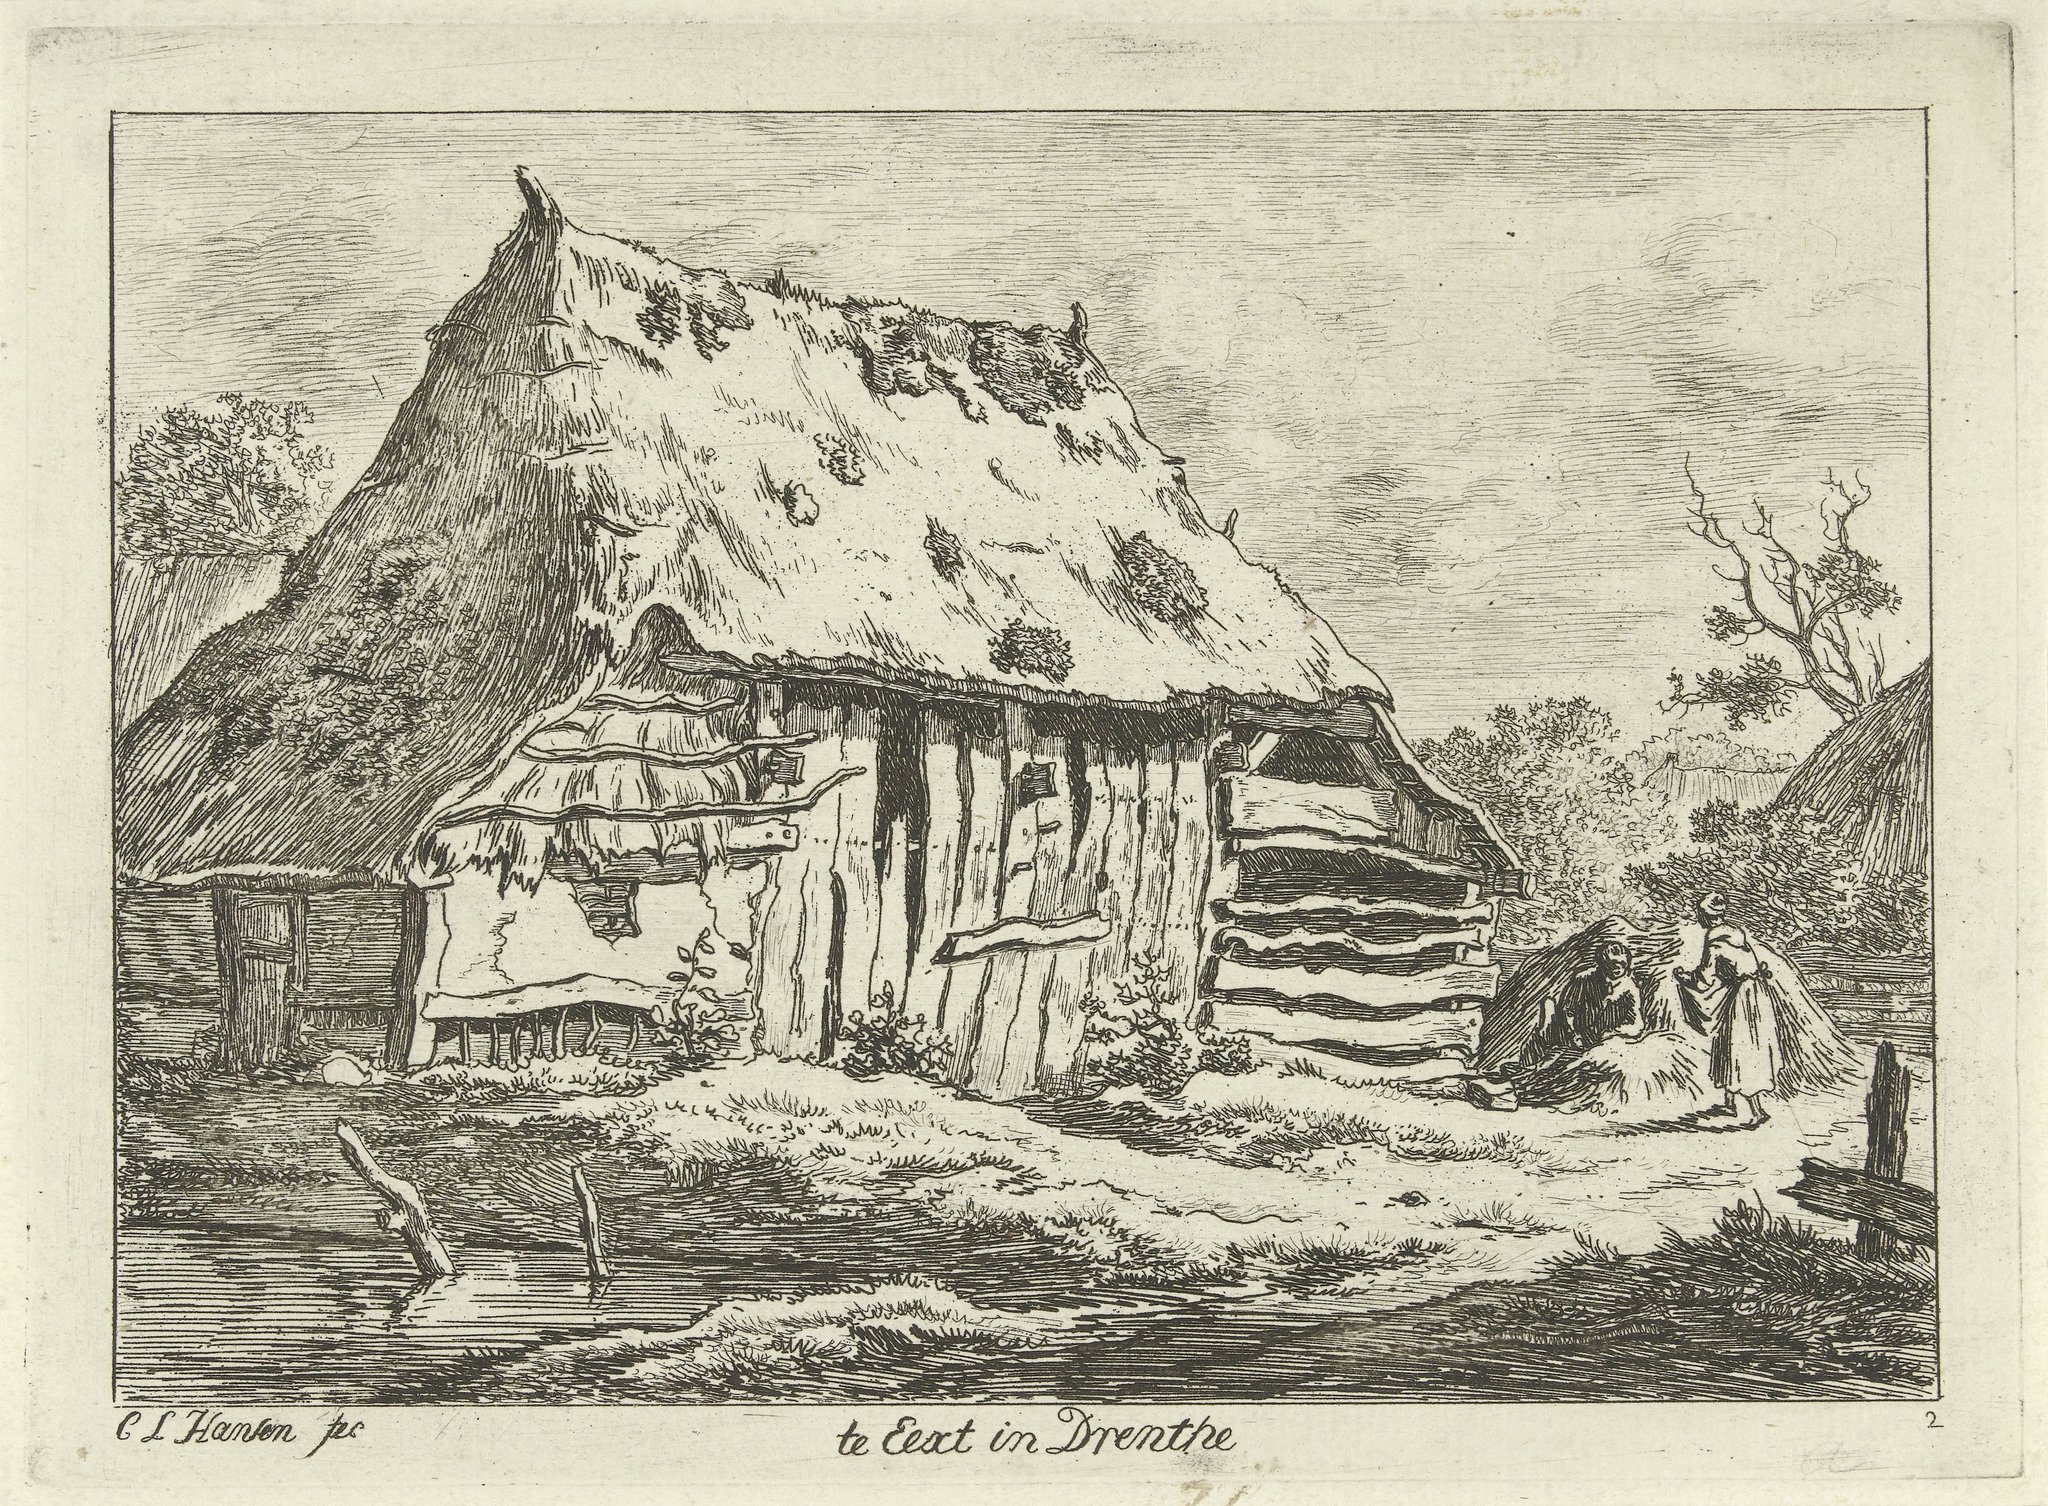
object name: print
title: Landschappen (1-6)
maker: carel lodewijk hansen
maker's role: draughtsman, painter, print maker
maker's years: 1765-1840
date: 1780-1840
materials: paper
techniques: etching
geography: netherlands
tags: farm or solitary house in landscape (+ city(-scape) with figures, staffage)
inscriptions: collector's mark: Lugt 2228